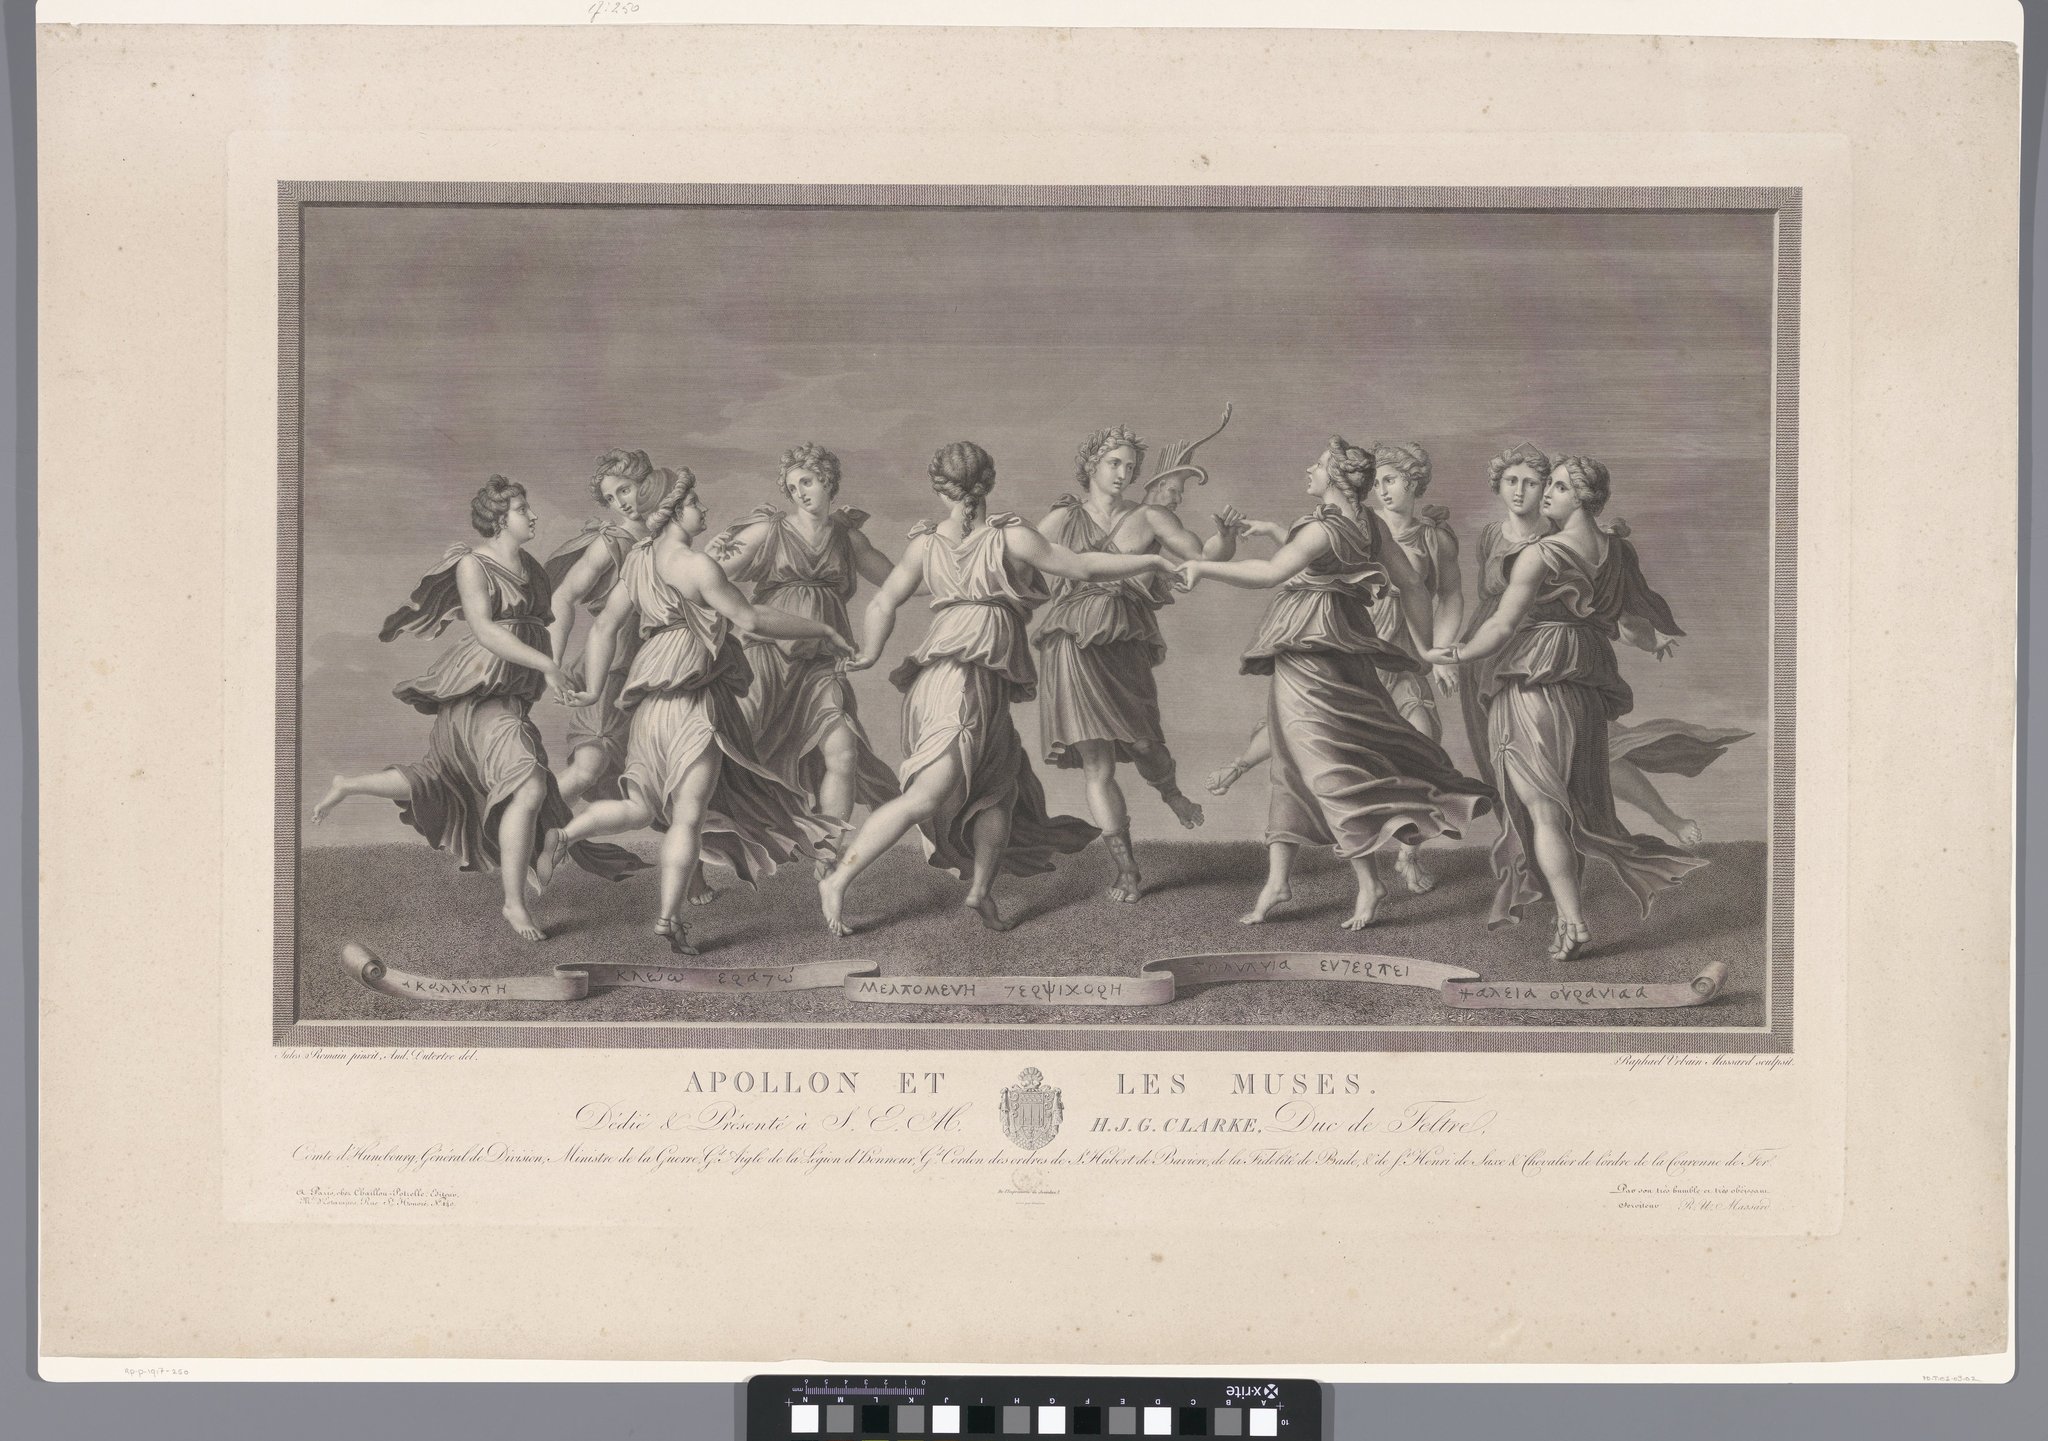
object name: print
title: Apollon et les muses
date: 1821-1833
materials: paper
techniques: engraving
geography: paris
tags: (story of) apollo (phoebus), the muses acting together (as group)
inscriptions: check stamp: Lugt 619, collector's mark: Lugt 2228